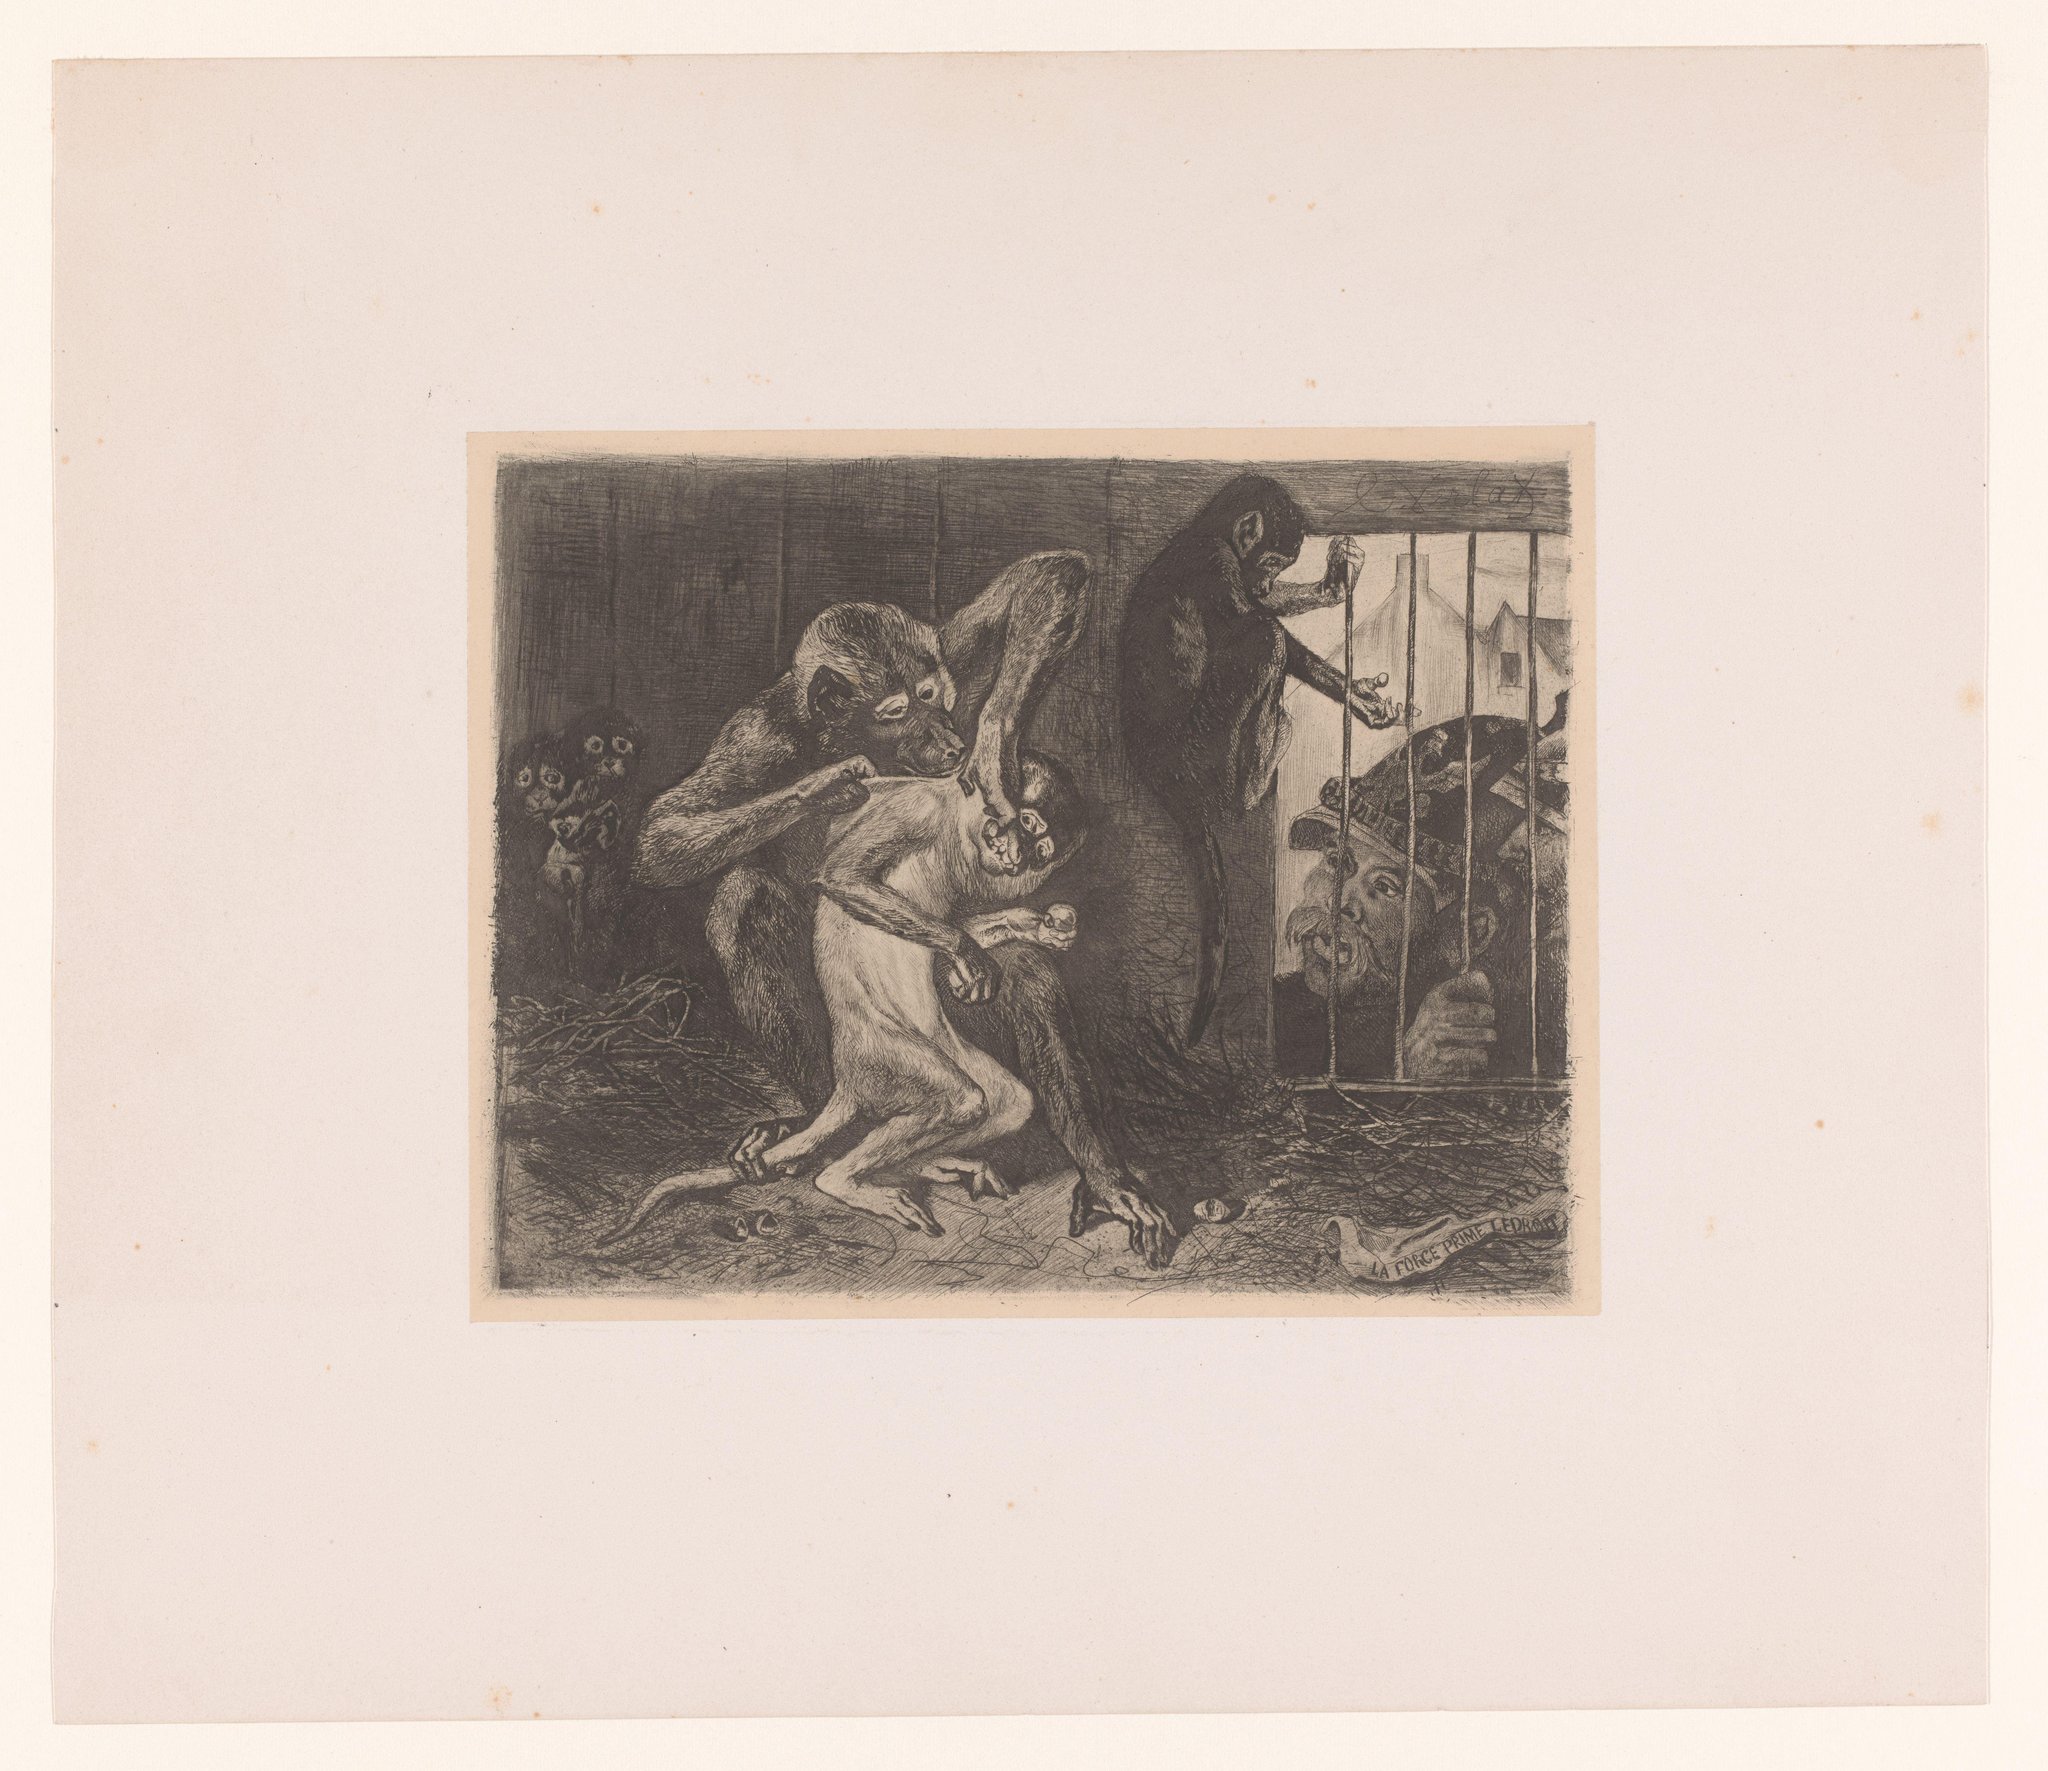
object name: print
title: Otto von Bismarck bij een kooi met apen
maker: charles verlat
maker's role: painter, print maker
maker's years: 1824-1890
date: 1850-1890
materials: paper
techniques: drypoint, etching, intaglio, retroussage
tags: official; civil servant; functionary (in general), monkeys, apes, historical persons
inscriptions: collector's mark: Lugt 2228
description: De Pruissische staatsman Otto von Bismarck kijkt door de tralies van een kooi waarin een aap met geweld een andere aap besteelt van zijn voedsel. Op de voorgrond een doek met daarop Von Bismarcks uitspraak "La force prime le droit".